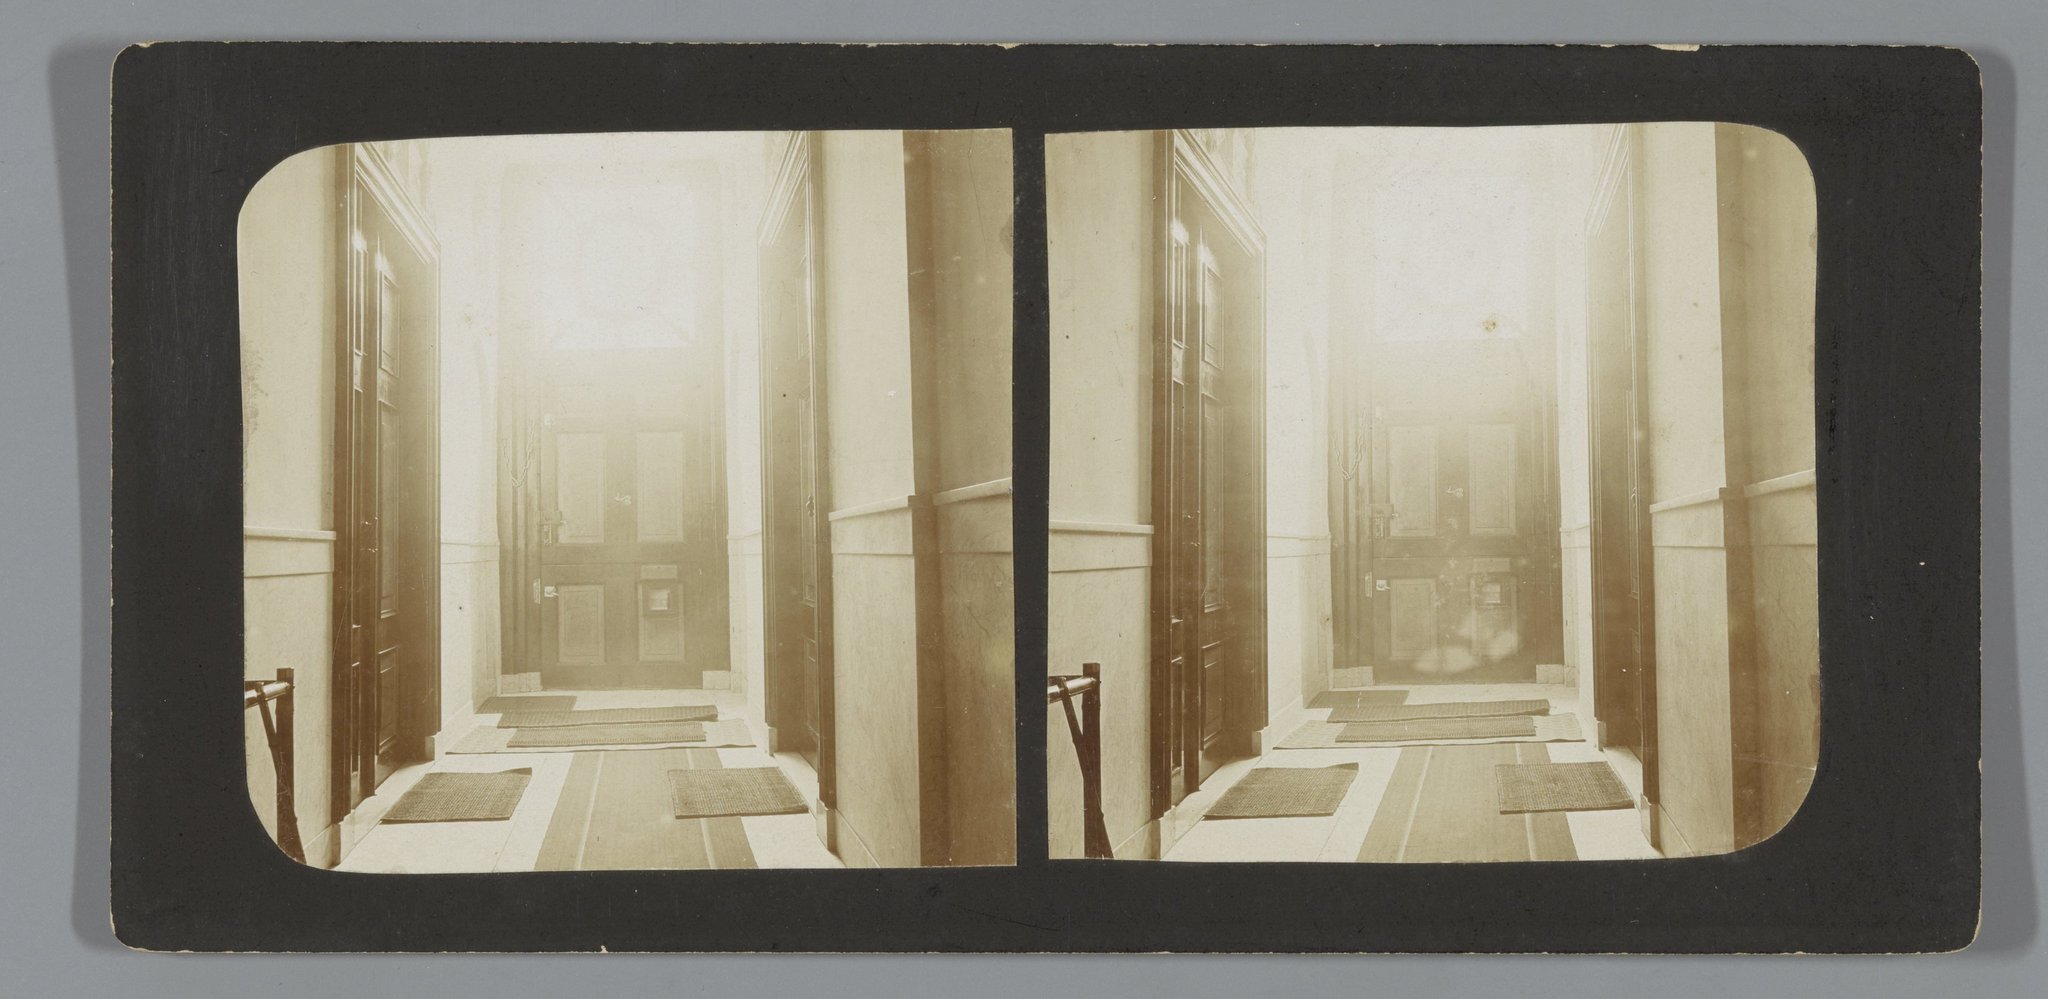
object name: stereograph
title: Gang van het huis aan Singel 256, Amsterdam, Nederland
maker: adrianus scheltema-beduin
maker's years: 1864-1944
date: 1899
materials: paper, cardboard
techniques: collodion silver print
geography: amsterdam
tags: vestibule, hall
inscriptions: inscription: ‘huis Singel 256 te Amsterdam/ Onze gang/ naar voren gezien/ 22 Oct 99.’